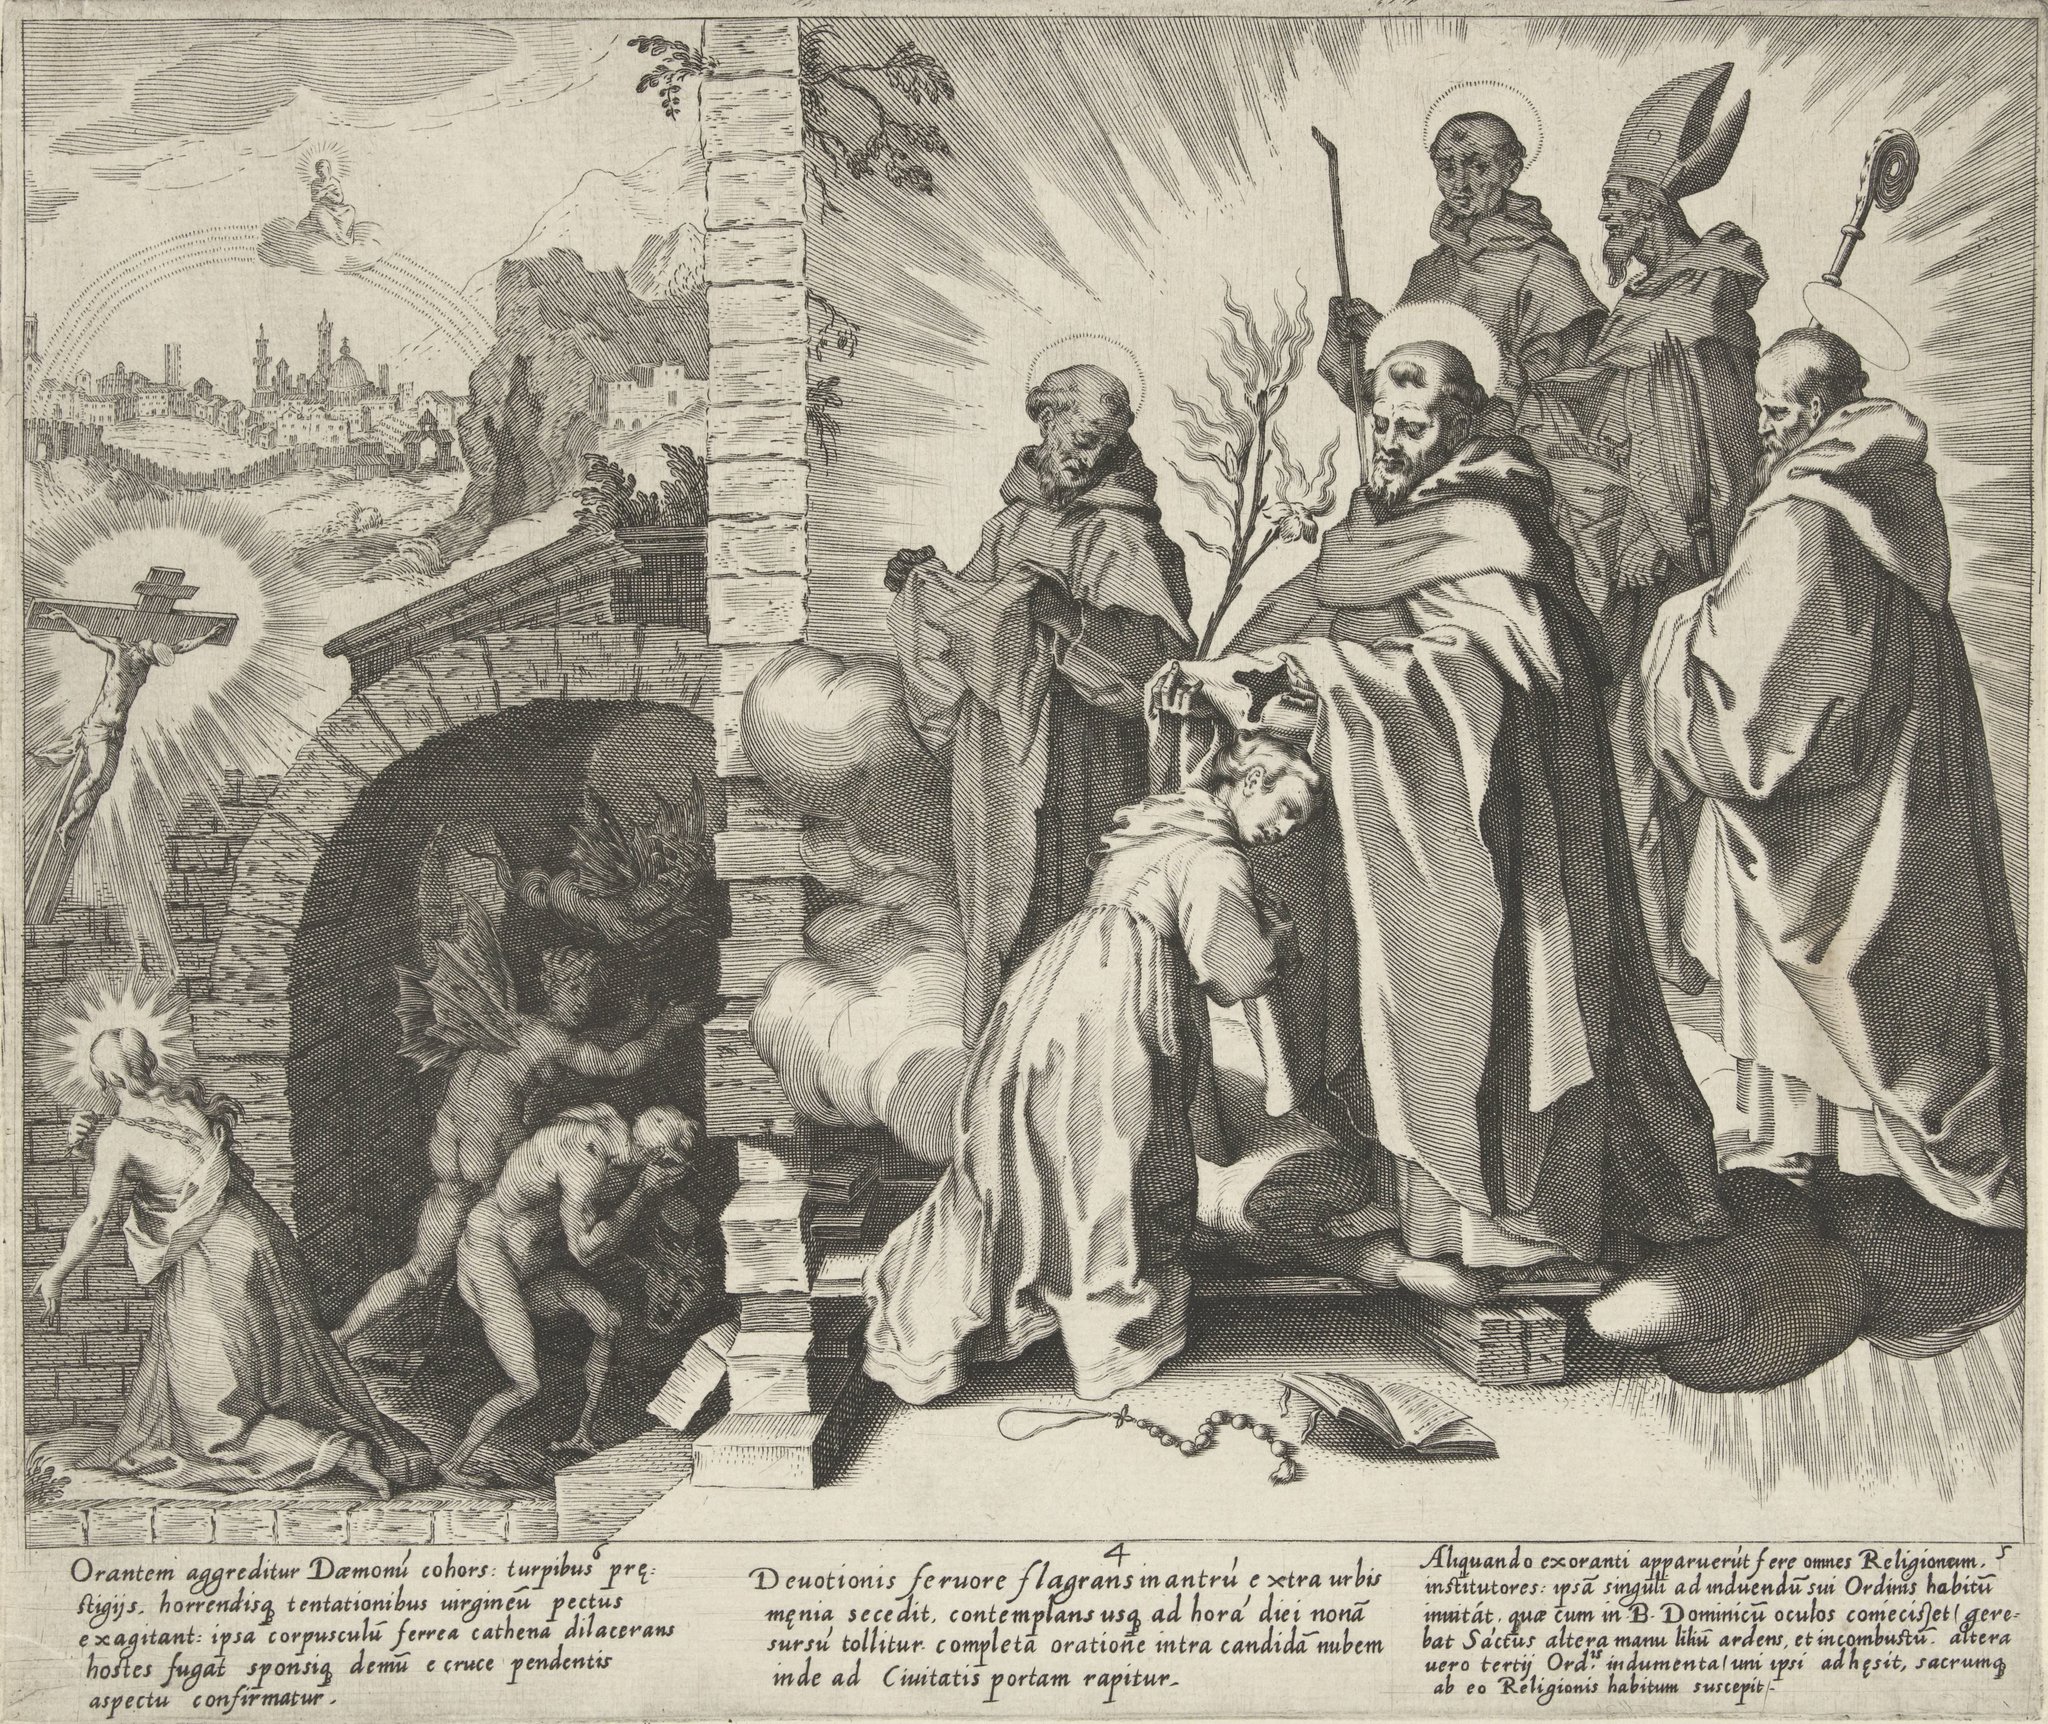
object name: print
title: Catharina biddend / Visioen van Catharina / Catharina wordt dominicanes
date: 1597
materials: paper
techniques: engraving, etching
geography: italy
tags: the virgin and dominican tertiary, catherine of siena; possible attributes: book, cross, crown of thorns, crucifix, demon under foot, heart (with cross), lily, plague-stricken, ring, rosary, stigmata, visions of st. catherine of siena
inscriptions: collector's mark: Lugt 240